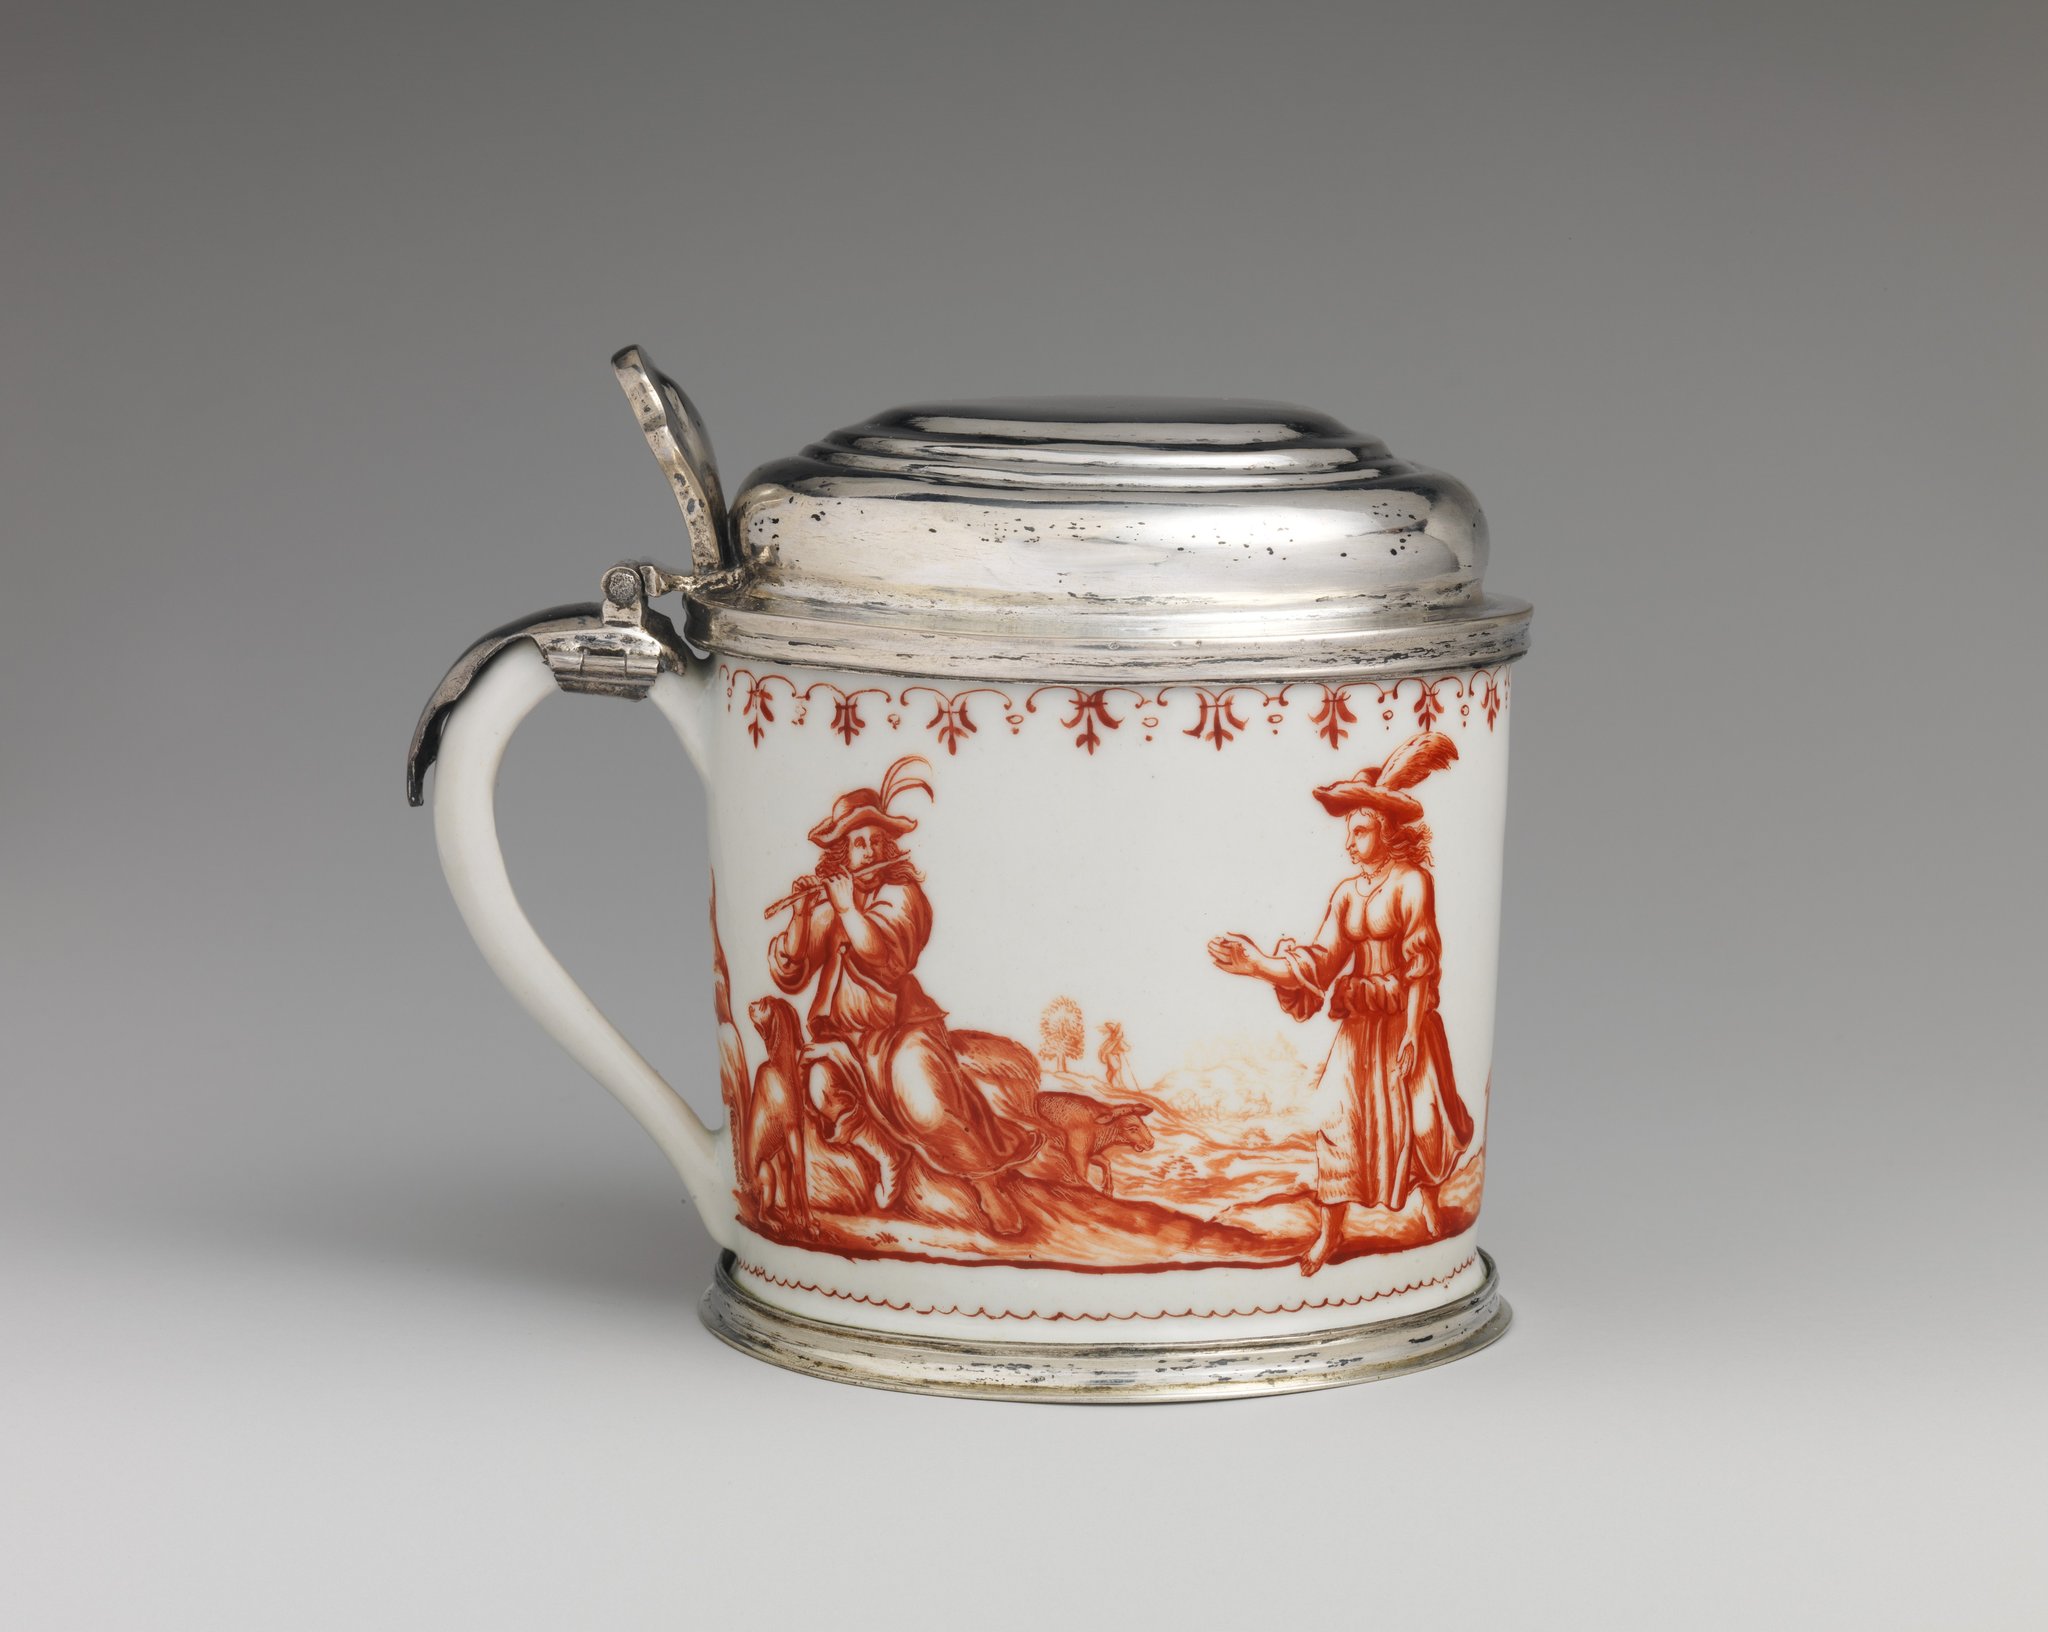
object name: tankard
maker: vienna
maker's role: manufactory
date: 1720-1725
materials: hard paste porcelain, silver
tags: animals,men,flutes